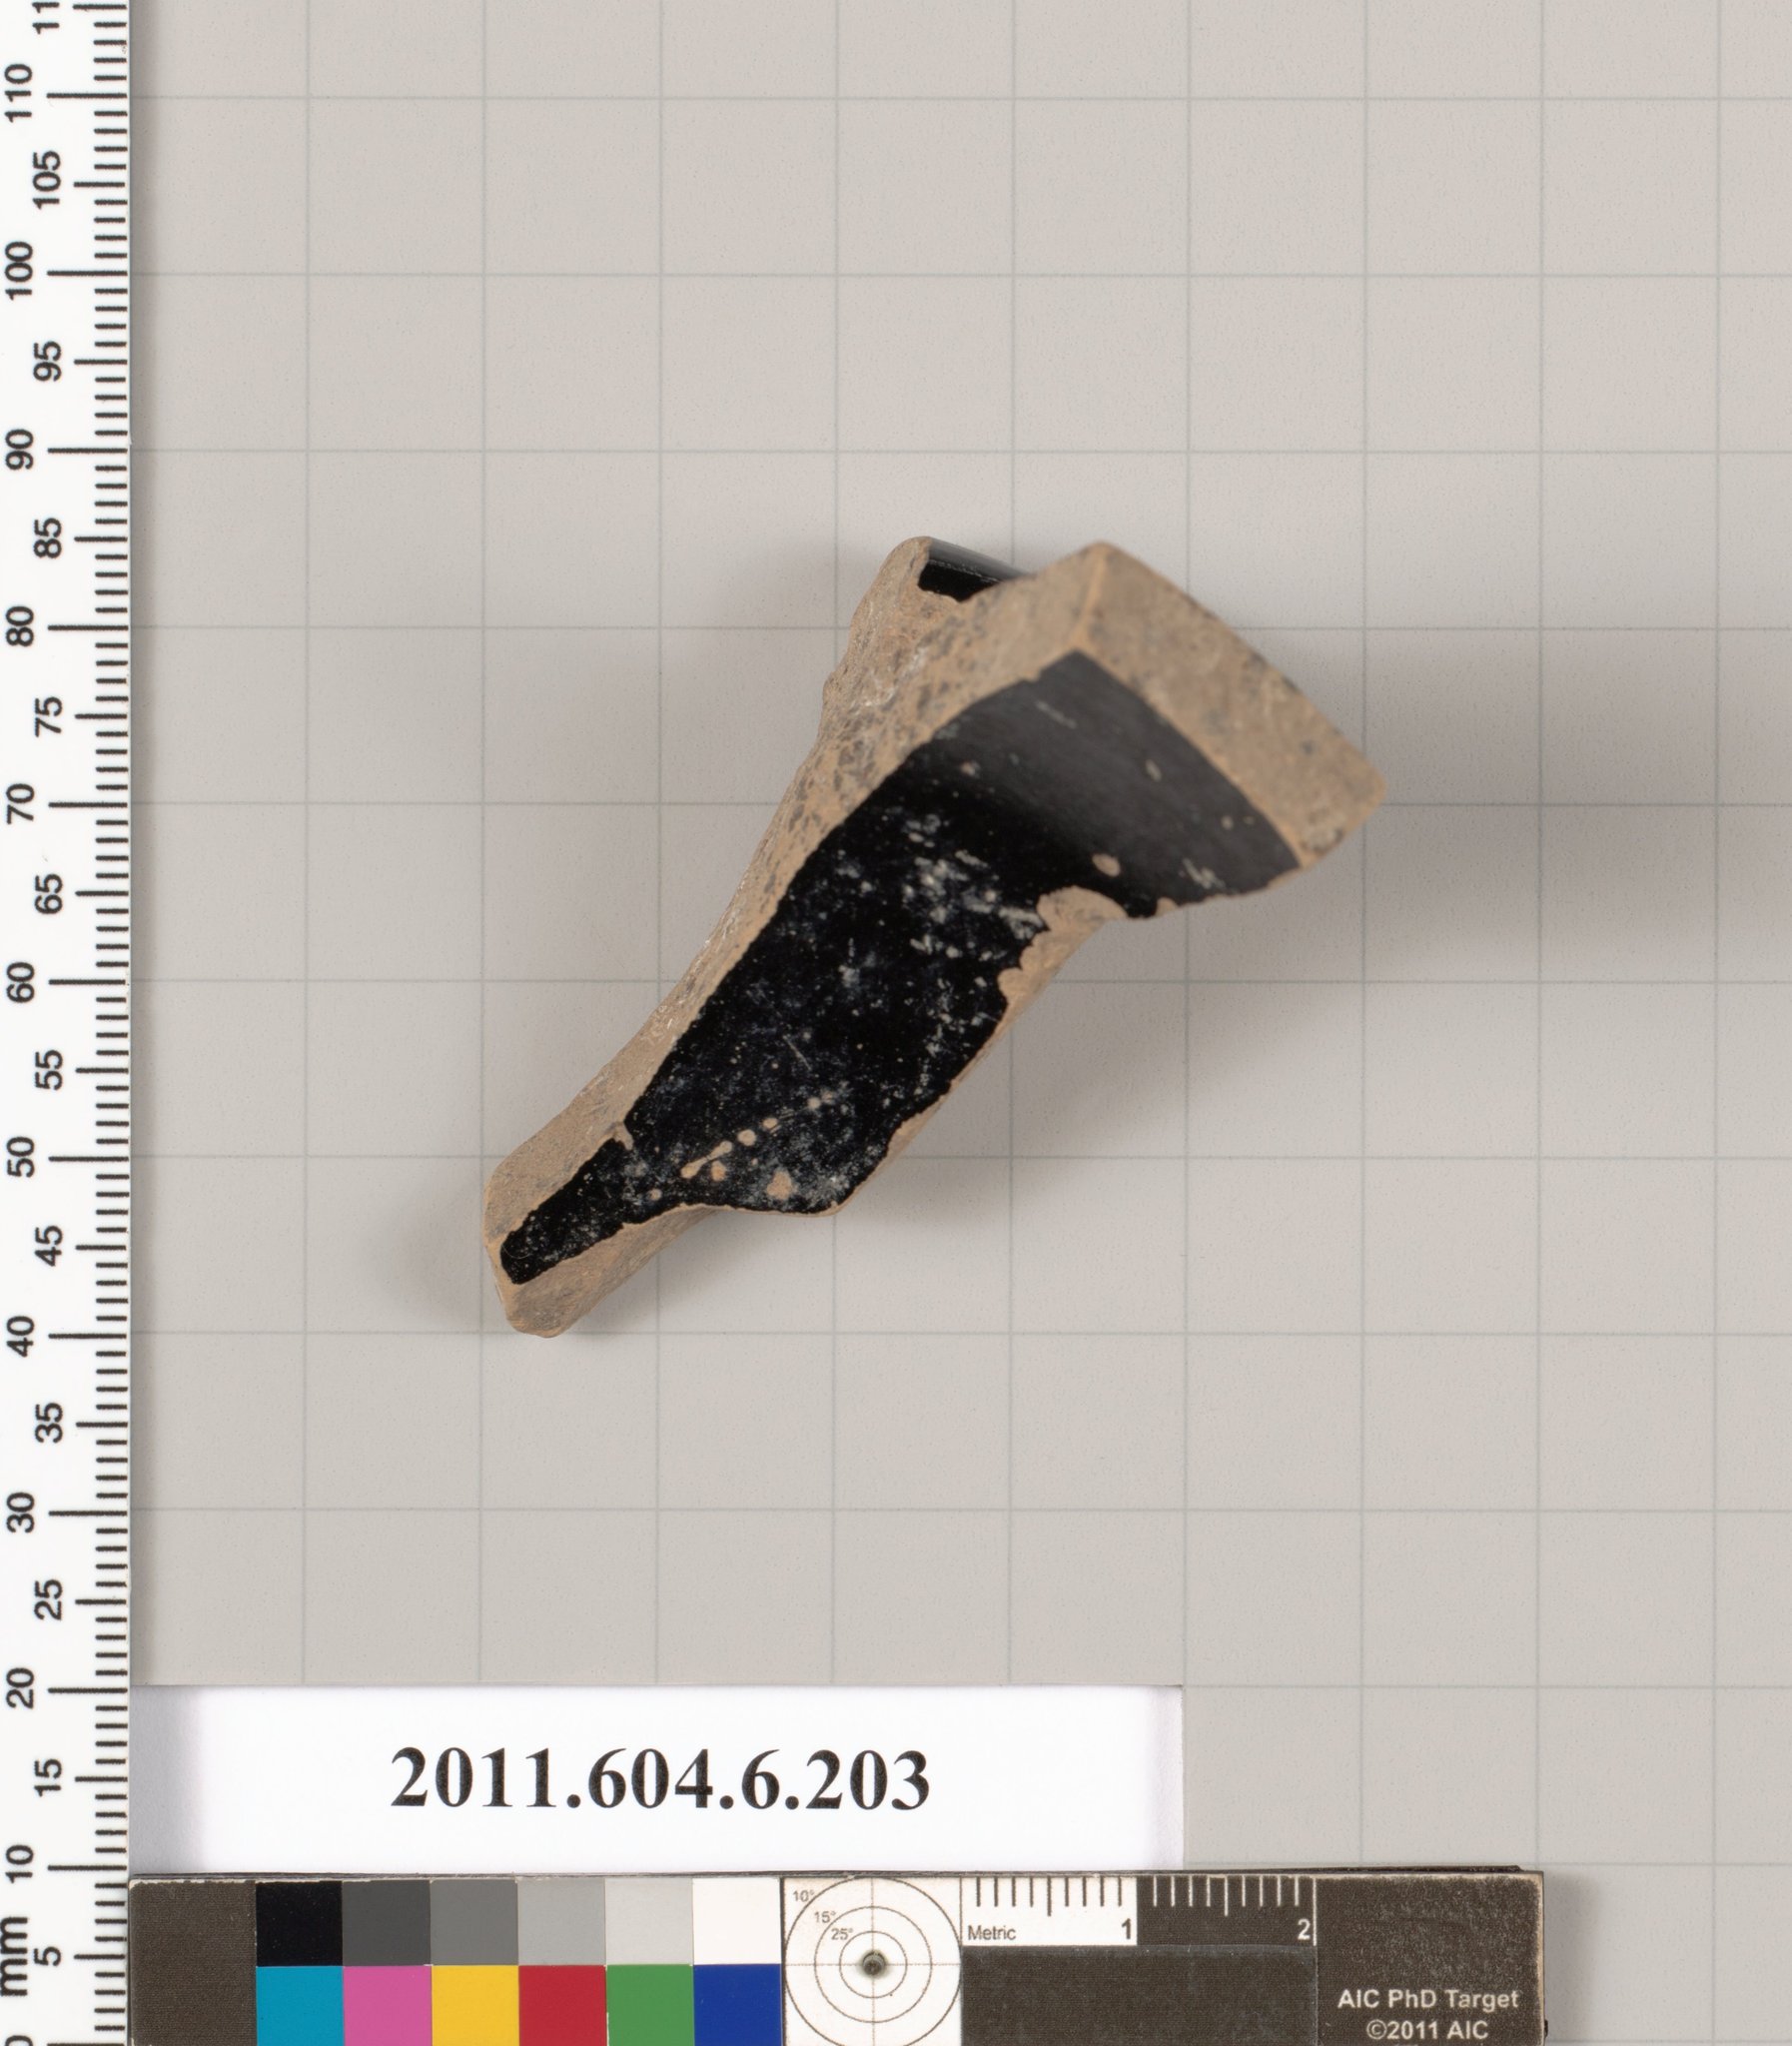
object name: skyphos fragment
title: Terracotta fragment of a skyphos (deep drinking cup)?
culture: greek, attic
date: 500-401 BCE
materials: terracotta